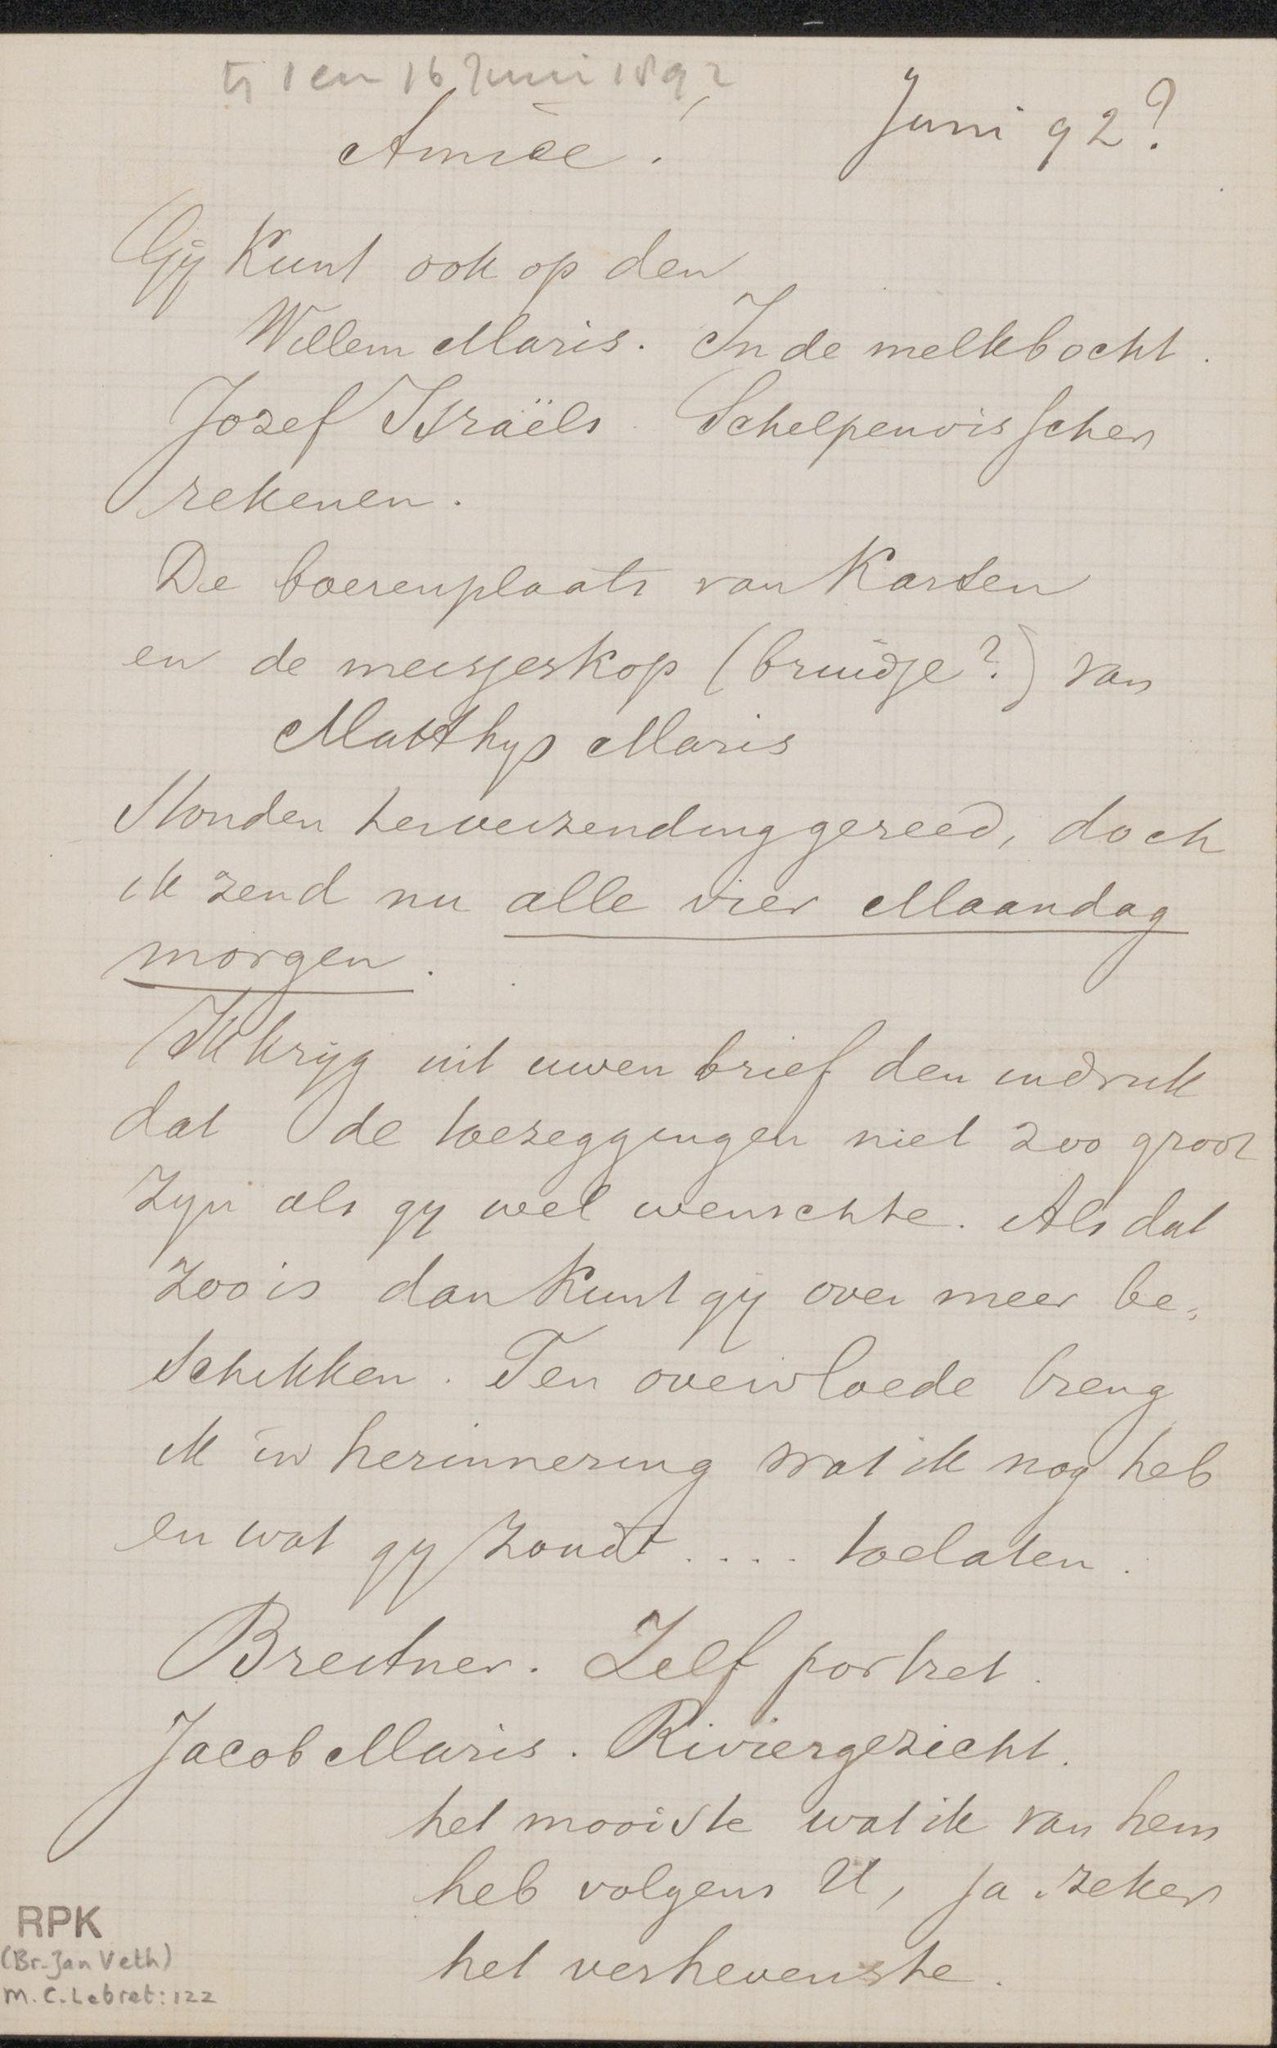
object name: letter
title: Brief aan Jan Veth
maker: martinus cornelis lebret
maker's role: verzamelaar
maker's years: 1833-1894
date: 1874-1894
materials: ink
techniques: pen, writing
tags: jozef israëls, johannes bosboom, rotterdam, george hendrik breitner, jan veth, willem maris, arnhem, painter, print maker, draughtsman, anton mauve, jacob maris, eduard karsen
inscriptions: collector's mark: ‘RPK’